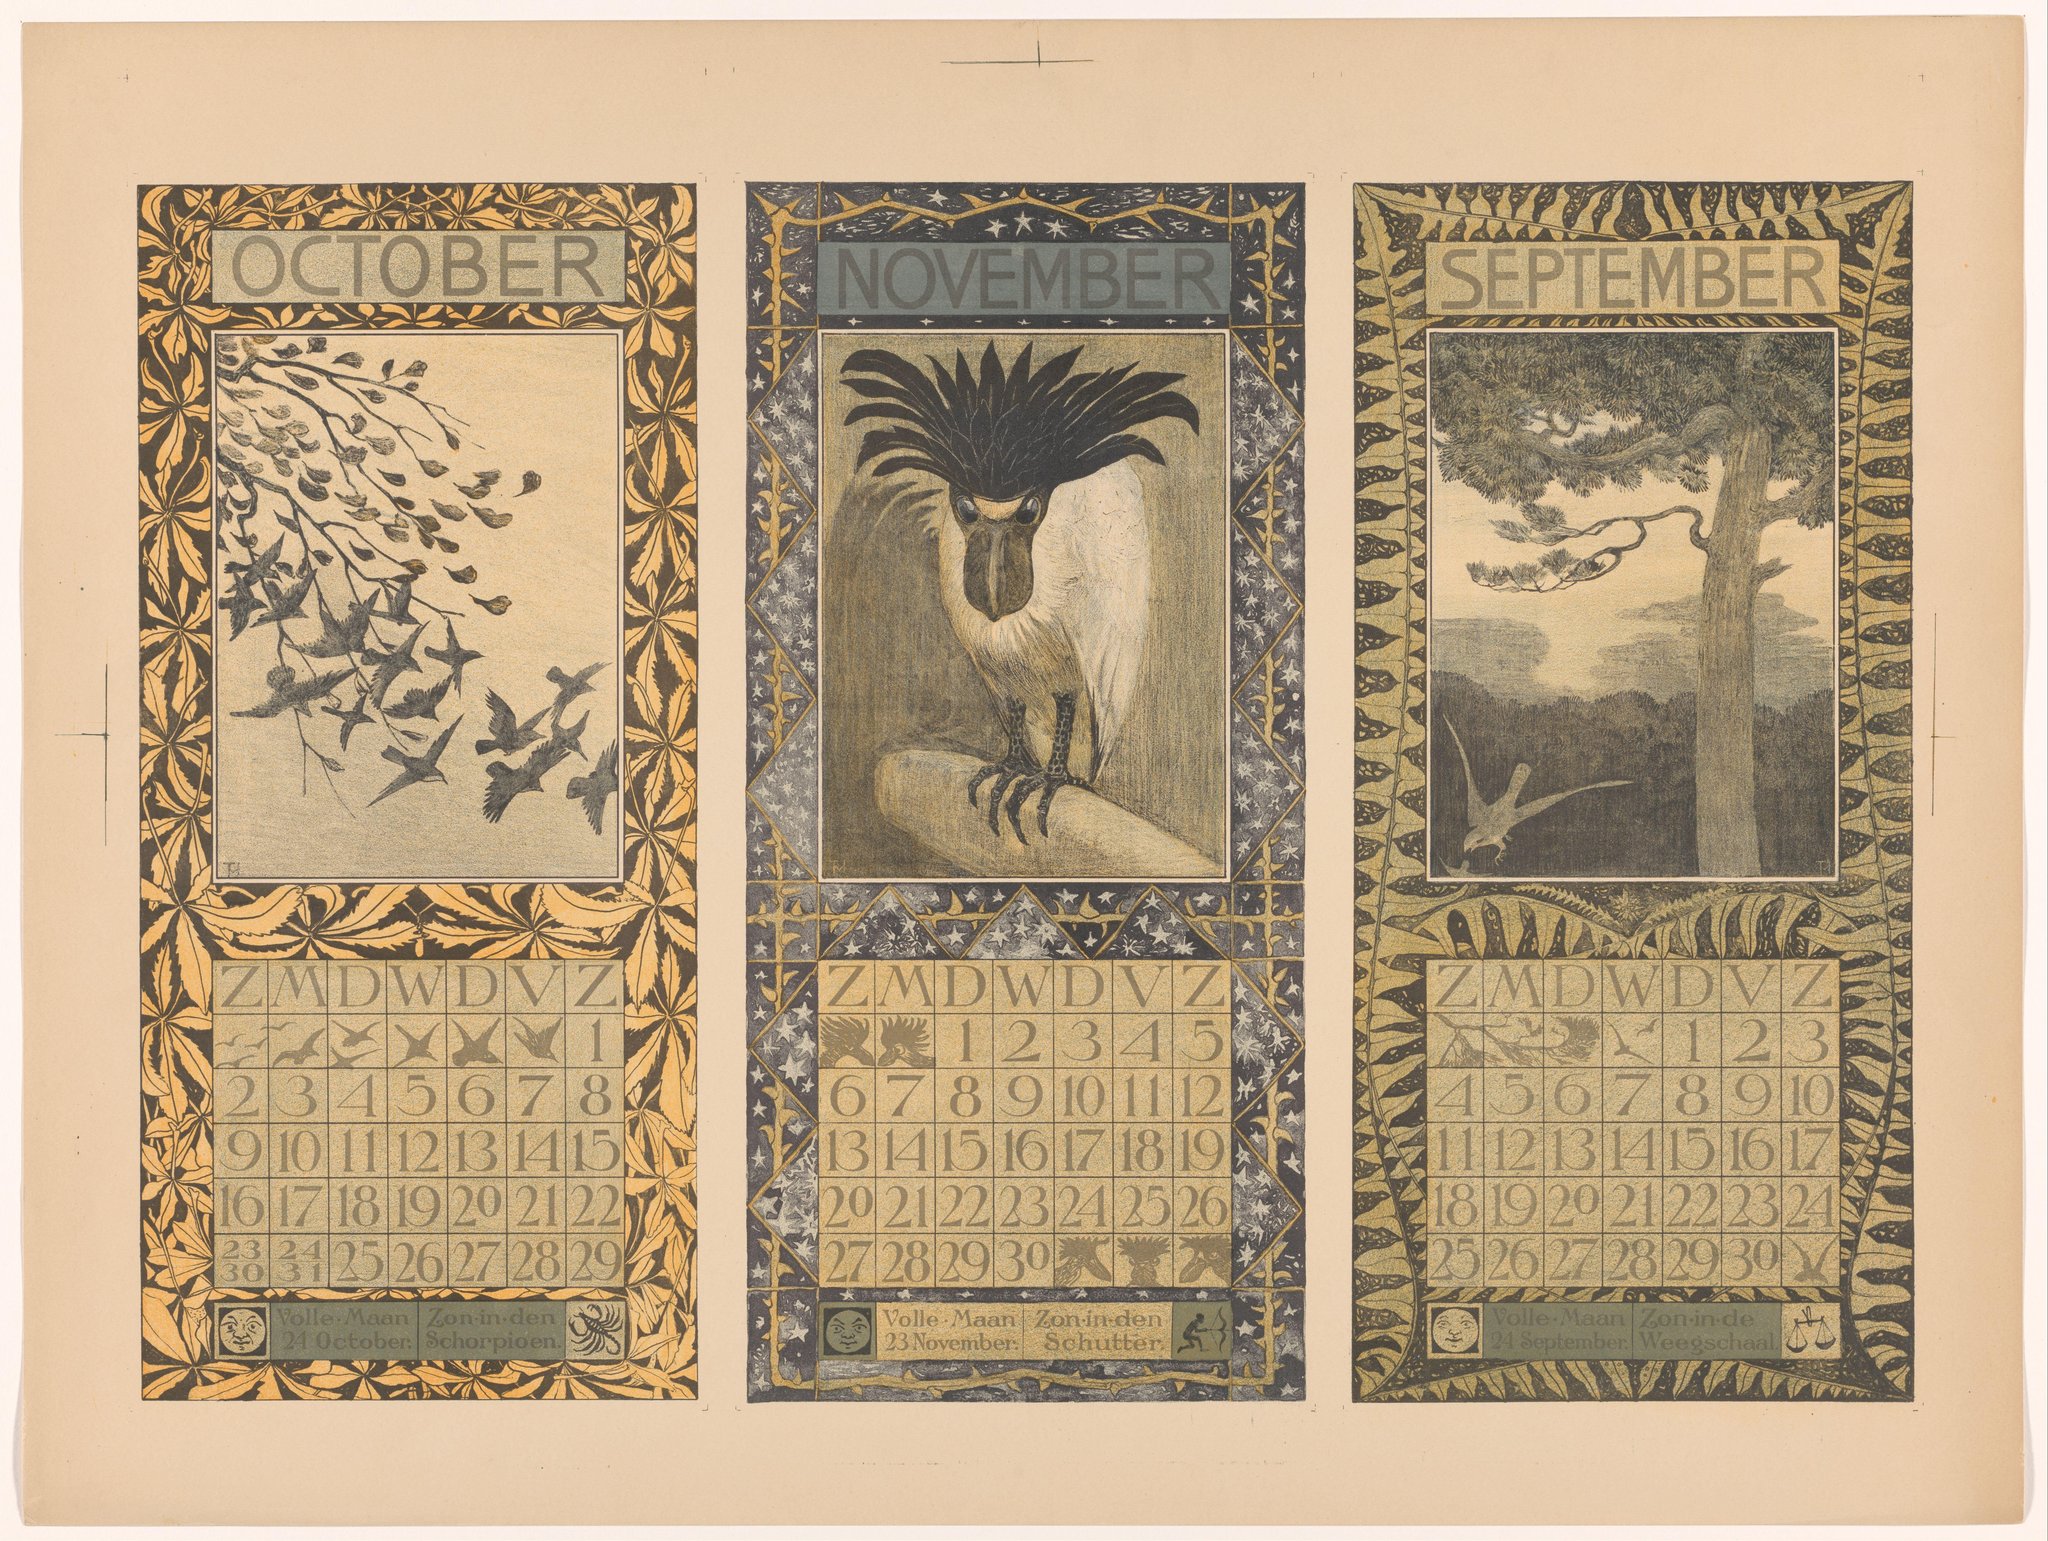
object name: print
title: Kalenders voor oktober, november en september 1904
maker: theo van hoytema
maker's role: draughtsman, painter, print maker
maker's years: 1863-1917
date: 1904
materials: paper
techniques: lithograph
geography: amsterdam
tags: predatory birds: falcon, calendar, almanac, shore-birds and wading-birds: heron, groups of birds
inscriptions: collector's mark: Lugt 2233